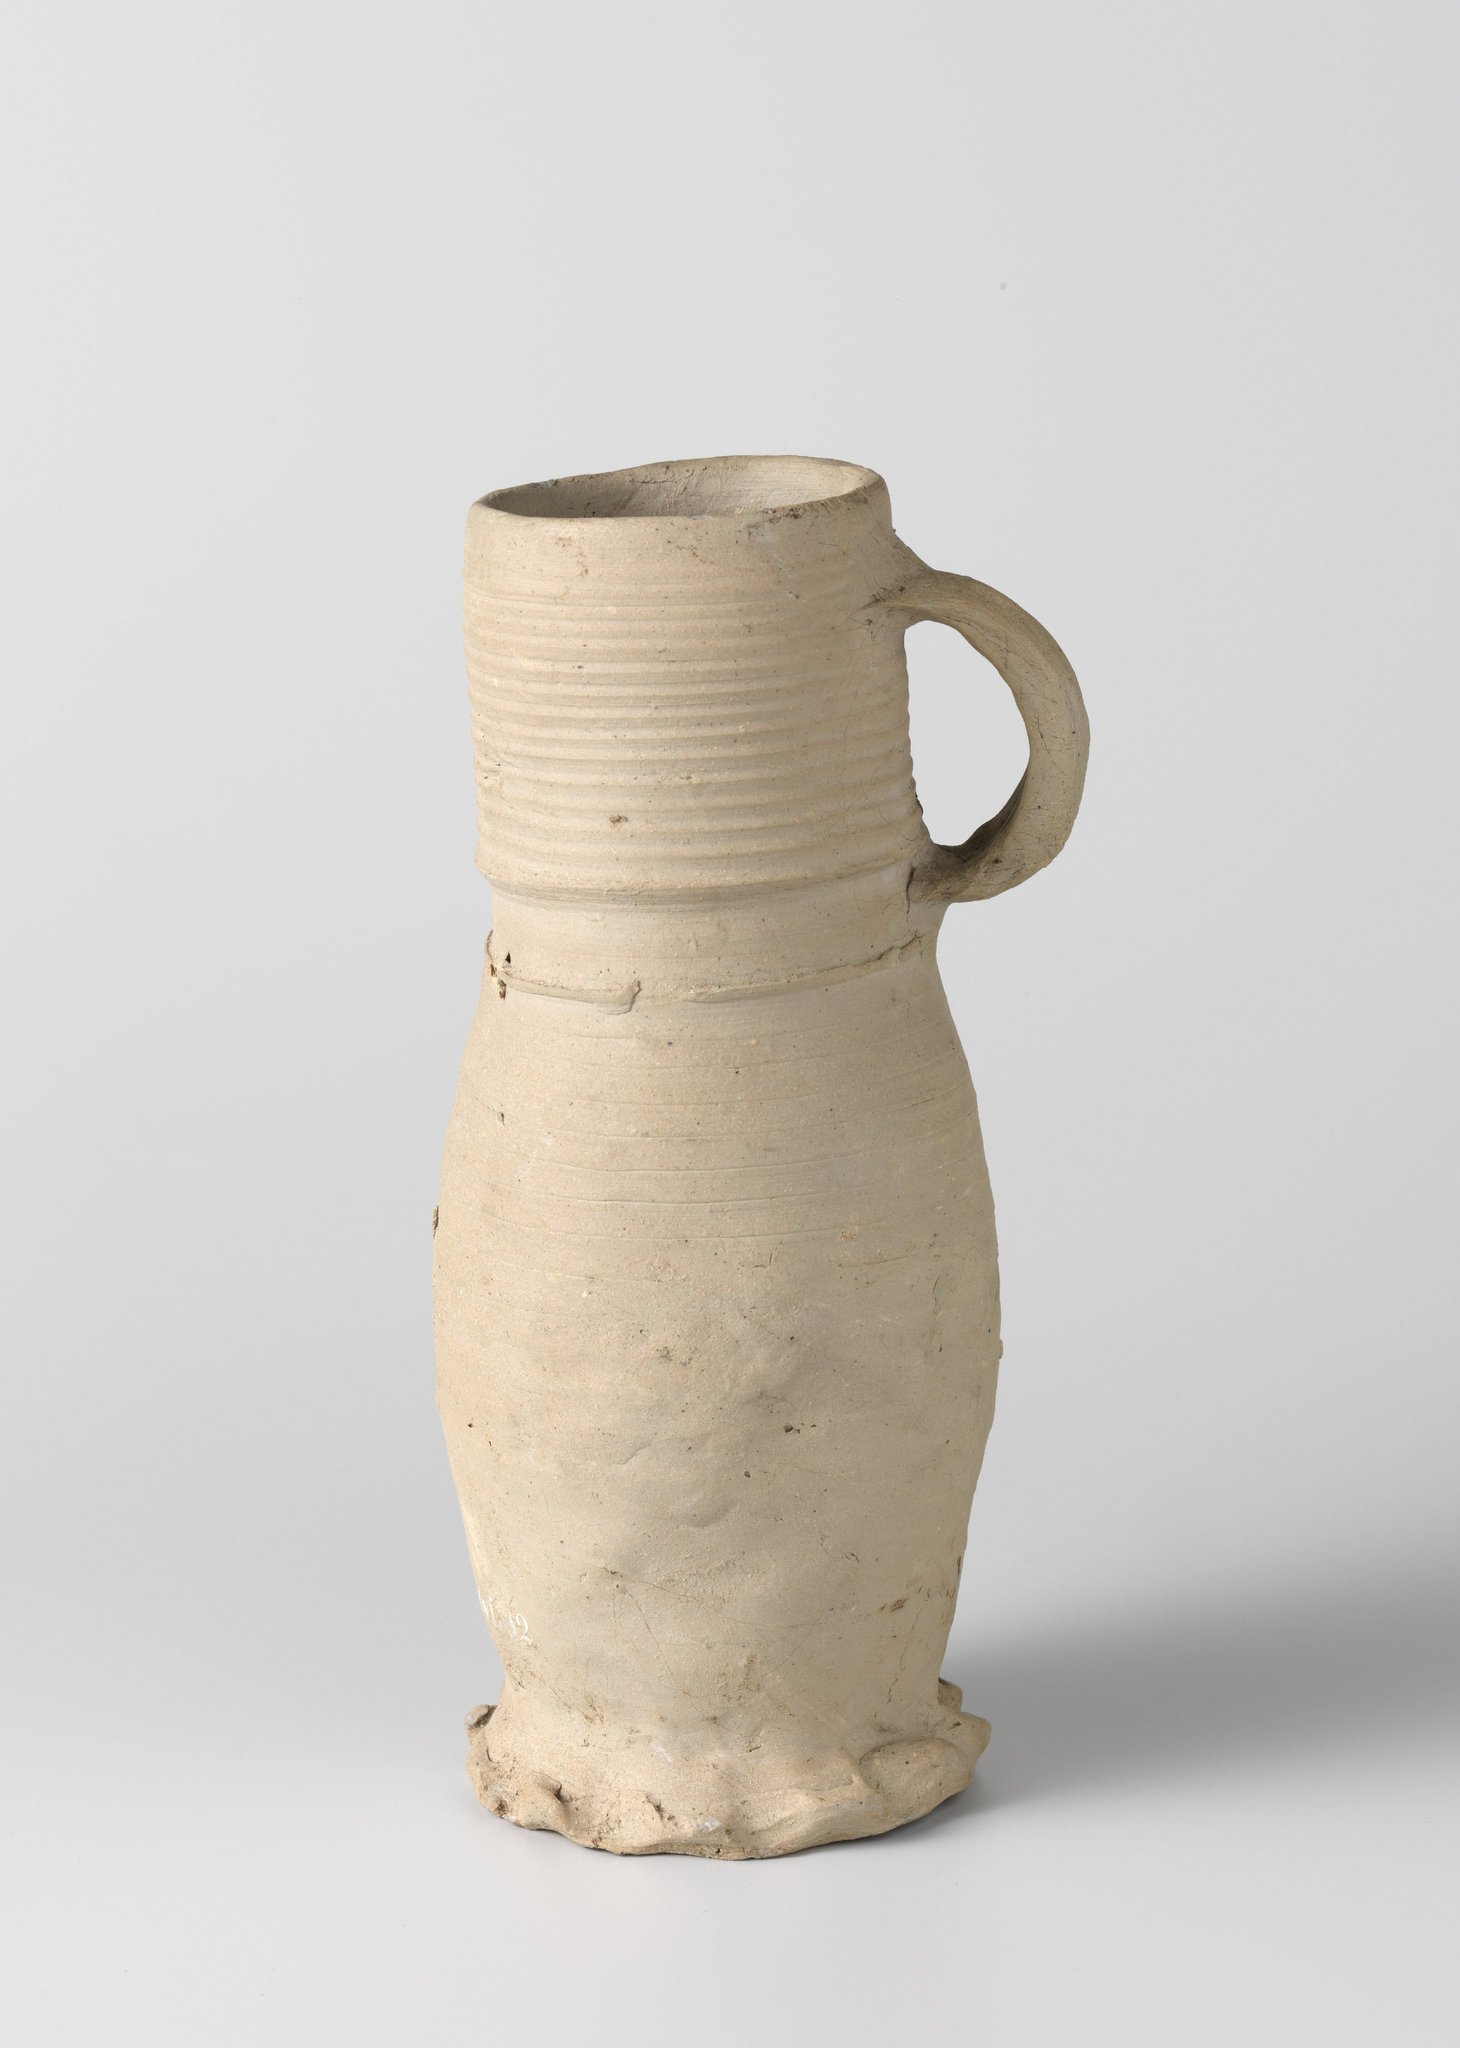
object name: ewer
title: Jacoba jug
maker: Anonymous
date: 1450-1499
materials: glaze, stoneware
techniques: firing, forming, turning, vitrification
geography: siegburg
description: Geribde kan (Jacobakan) van steengoed op golvende voet met een eivormig lichaam en lange nek. Het C-vormige oor is bevestigd aan de nek. De kan is versierd met draairingen en een profiel op de schouder. Siegburg.